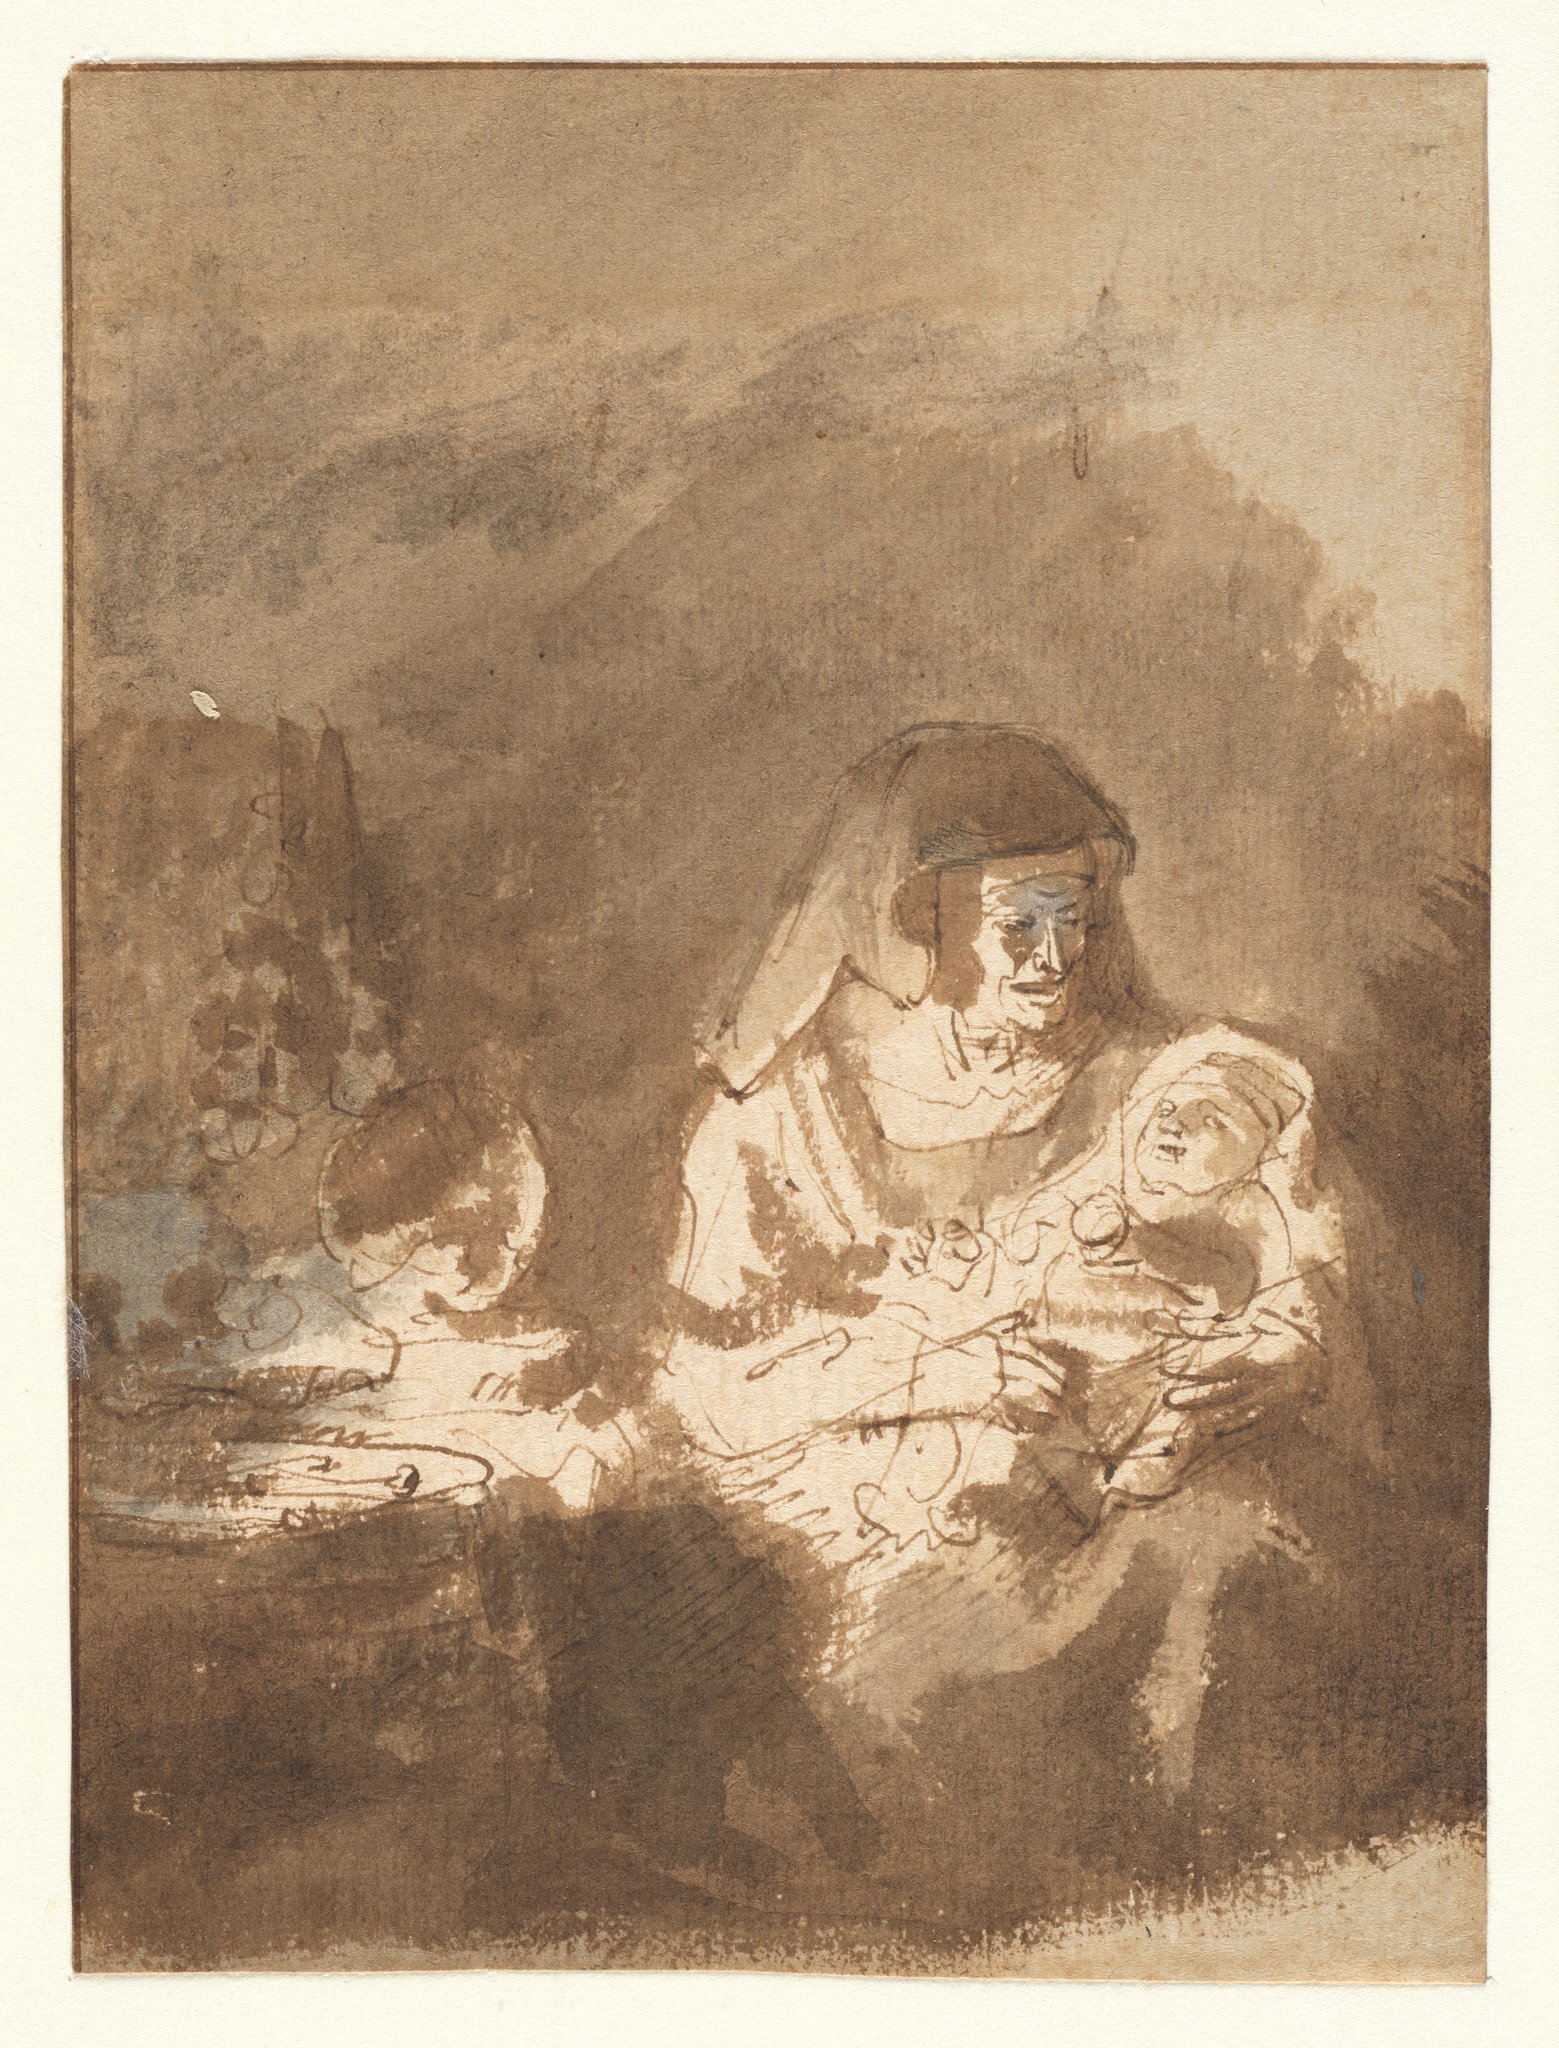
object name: drawing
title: Old Woman with a Baby in her Arms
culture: dutch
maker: school of rembrandt van rijn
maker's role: artist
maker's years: 1606-1669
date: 1643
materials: ink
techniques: pen, wash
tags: infants,women